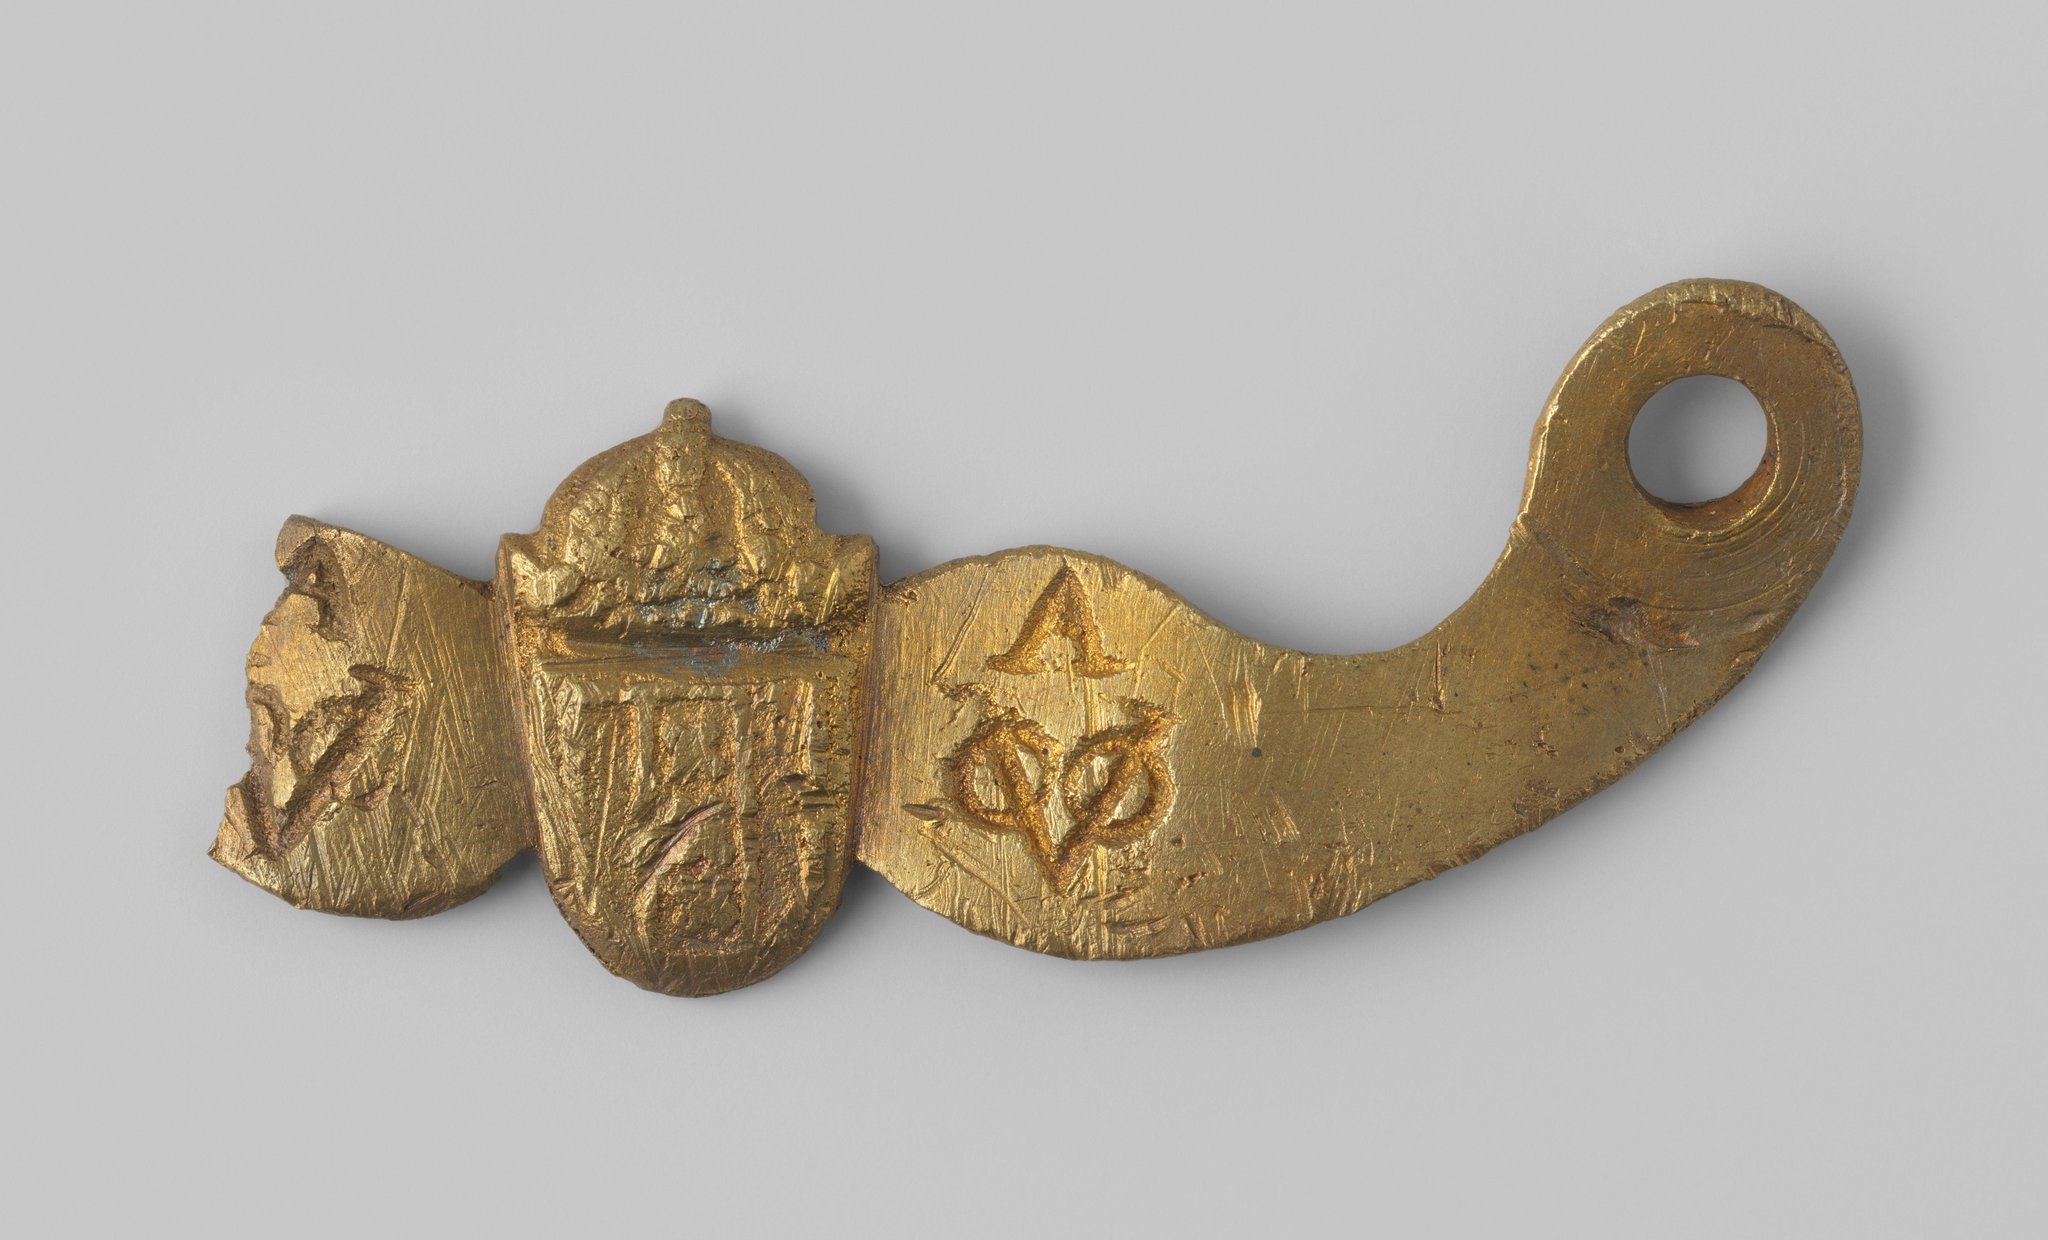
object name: musket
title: Fragment schroefplaat van een musket uit het wrak van de Oost-Indiëvaarder Hollandia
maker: Anonymous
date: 1700-1743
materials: copper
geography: netherlands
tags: verenigde oostindische compagnie, hollandia (schip), annet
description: Fragm, id. NG 1978-74H986 or NG 1980-27H3069, left wing broken off, side plate.